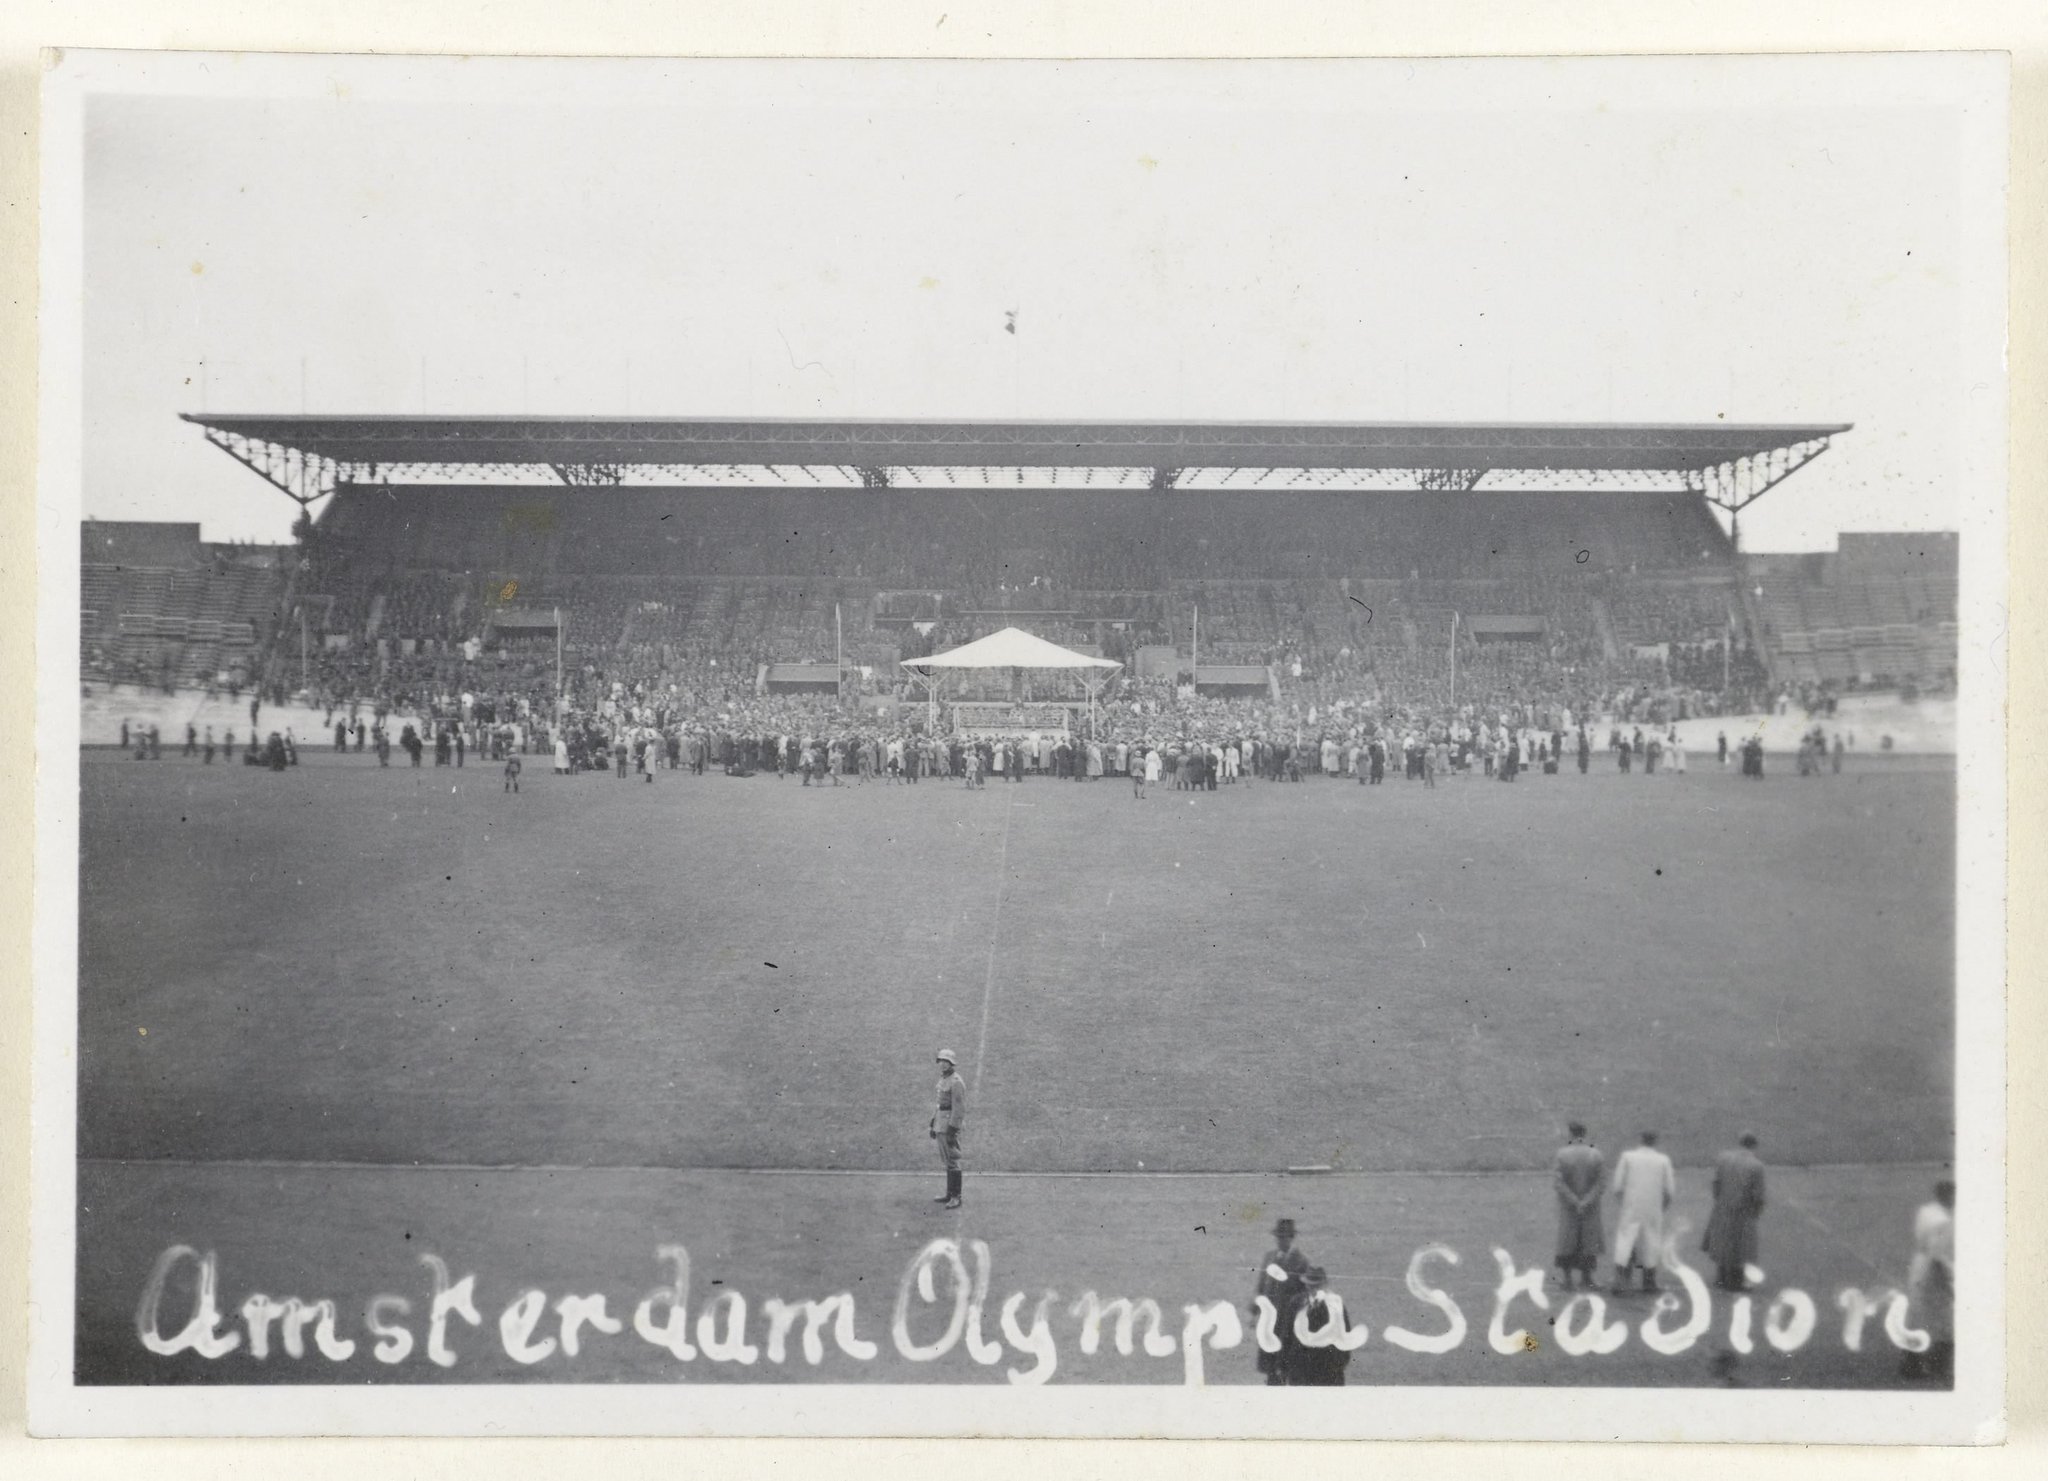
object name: photograph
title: Duitse soldaten in het Olympisch Stadion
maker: Anonymous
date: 1941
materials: photographic support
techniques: photography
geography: olympisch stadion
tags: military celebrations, occupation ~ war, amsterdam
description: Amateurfoto van Duitse soldaten uit 1941 in het Olympisch Stadion. Voor de tribune staat een tent, daaromheen grote groep mensen.